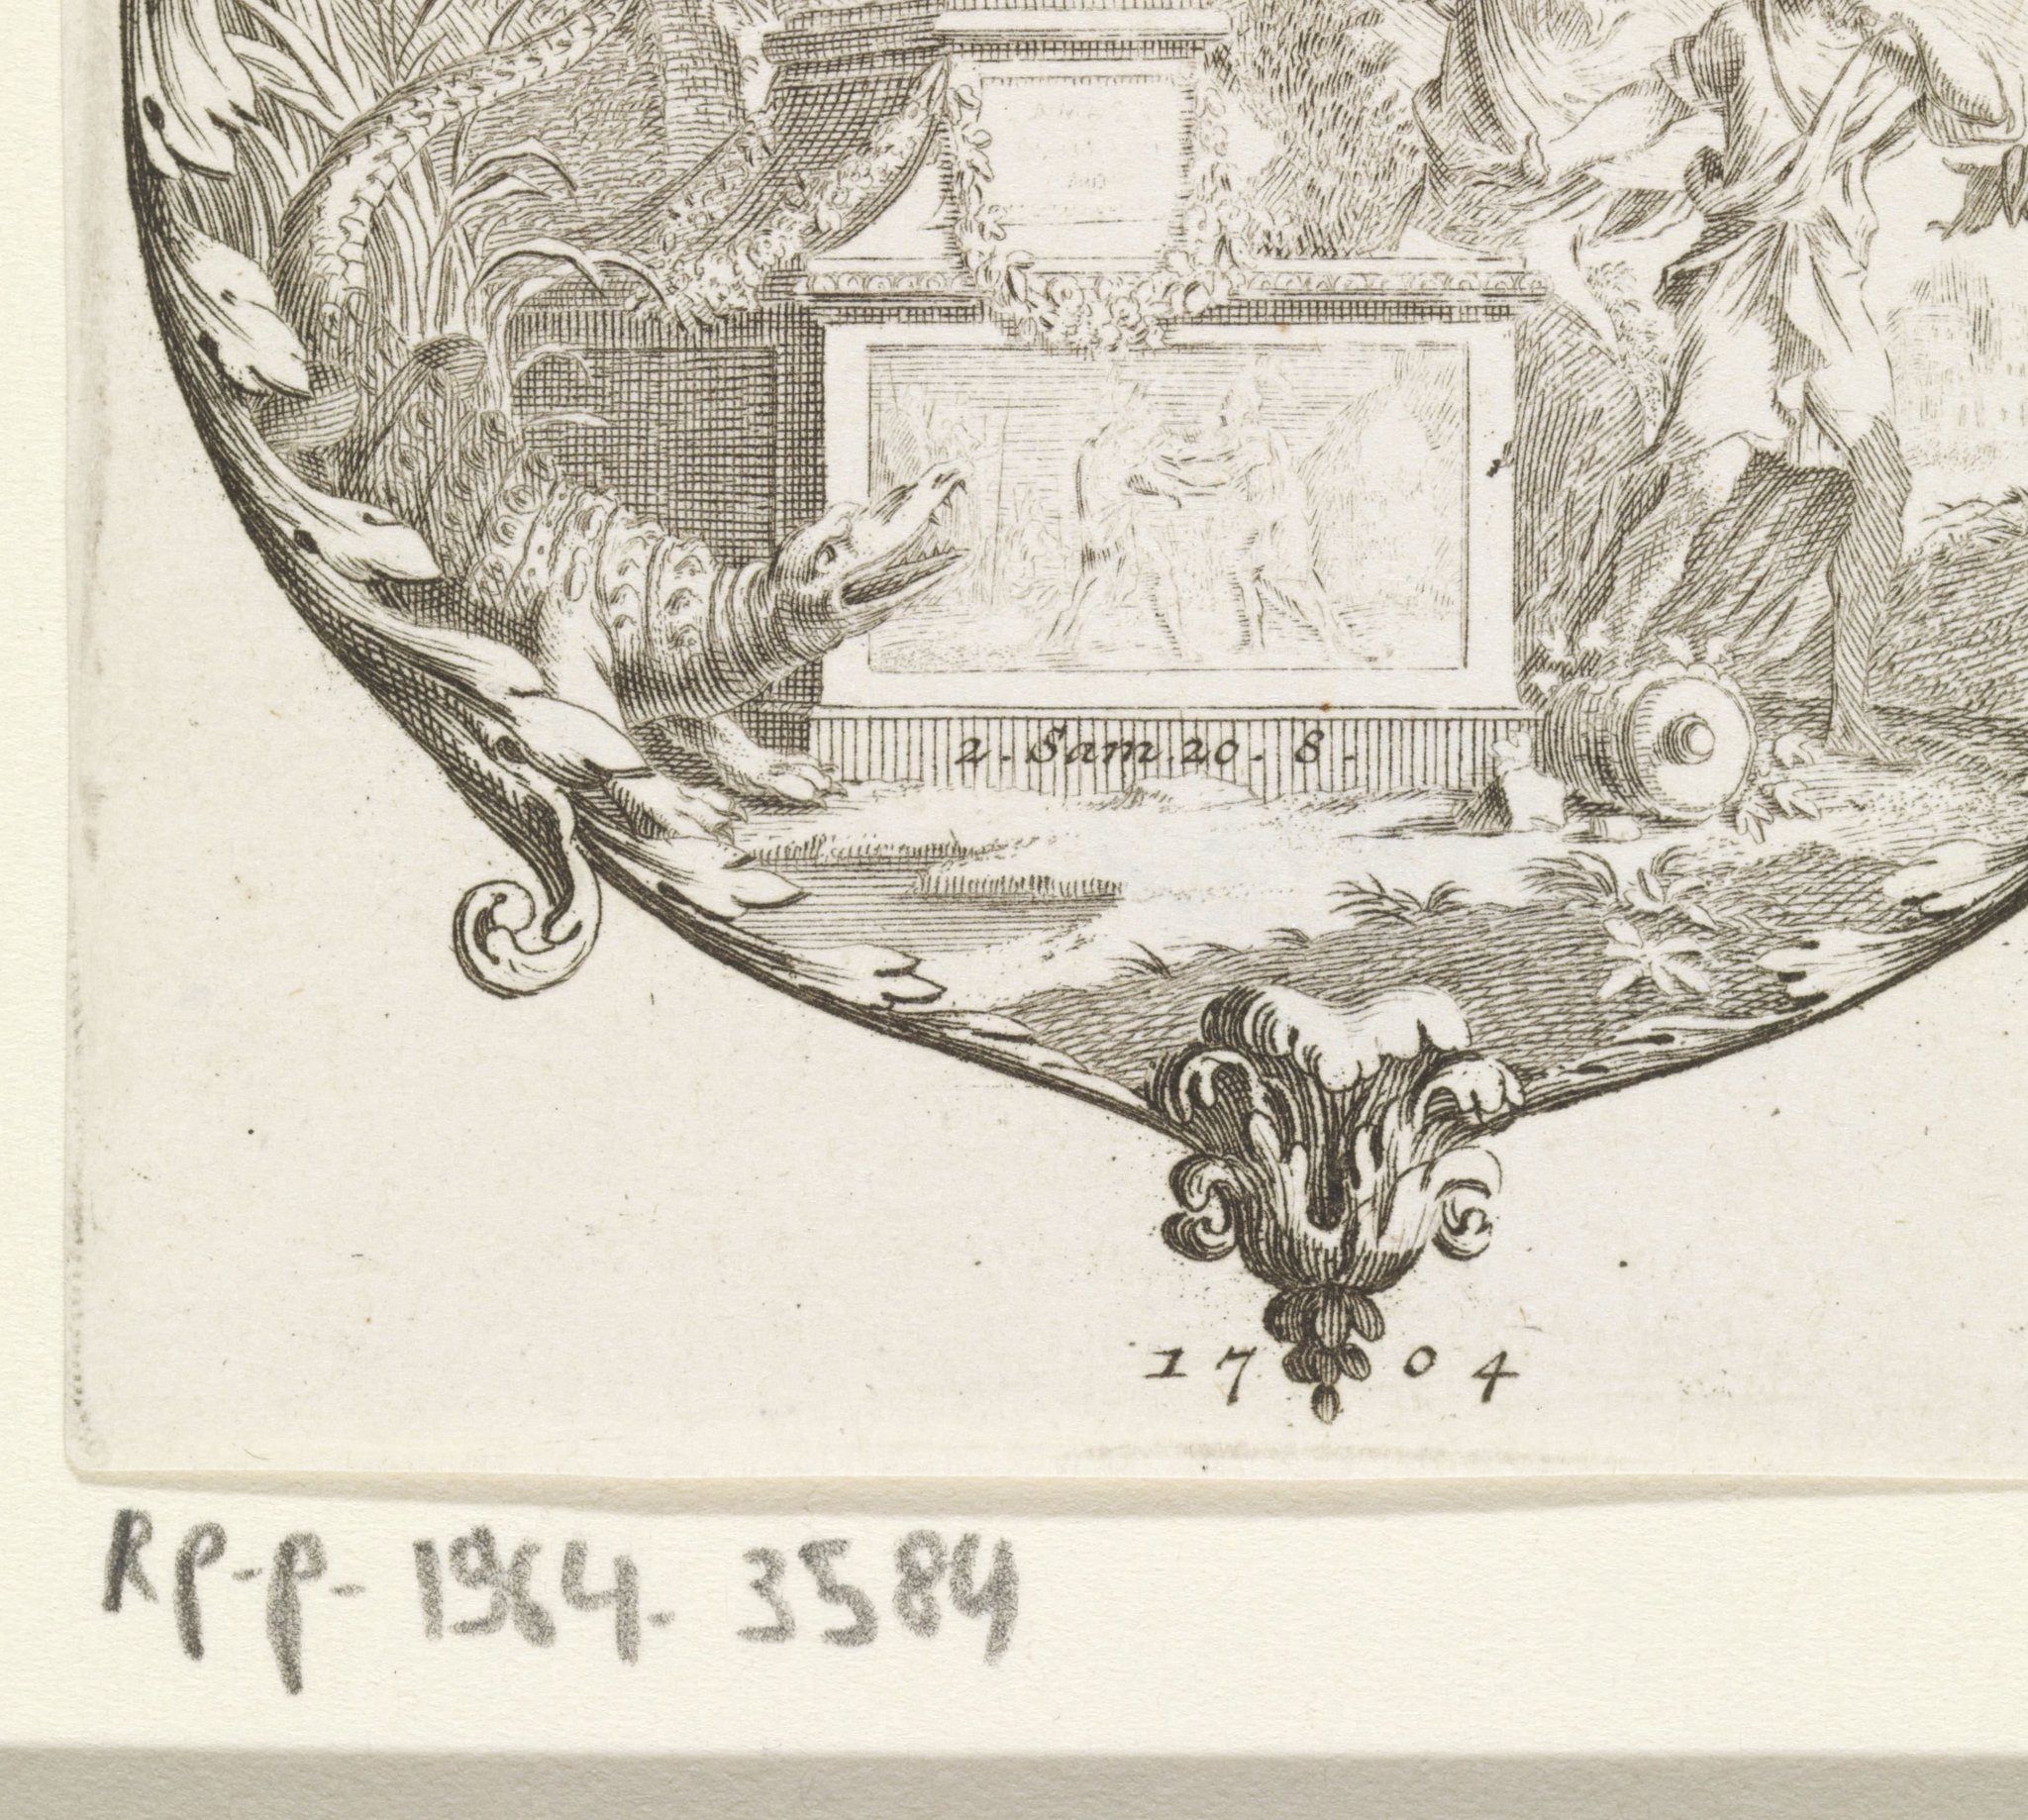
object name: book illustration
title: Sarcofaag met bijbelspreuk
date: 1704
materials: paper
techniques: engraving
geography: amsterdam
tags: crocodiles: crocodile, sarcophagus, speeches of christ against scribes and pharisees (matthew 23; mark 12:38-40; luke 11:42-52, 20:45-47)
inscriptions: collector's mark: Lugt 2228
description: Een hartvormige kader met daarin de voorstelling van een sarcofaag, met daarnaast enkele mannen. Aan de andere kant van de sarcofaag een krokodil. Een opschrift op het kader verduidelijkt dat het hier gaat om een verbeelding van het bijbelvers uit Matteüs 23:27: "Wee jullie, schriftgeleerden en Farizeeën, huichelaars, jullie lijken op witgepleisterde graven, die er vanbuiten wel fraai uitzien, maar vol liggen met doodsbeenderen en andere onreinheden".